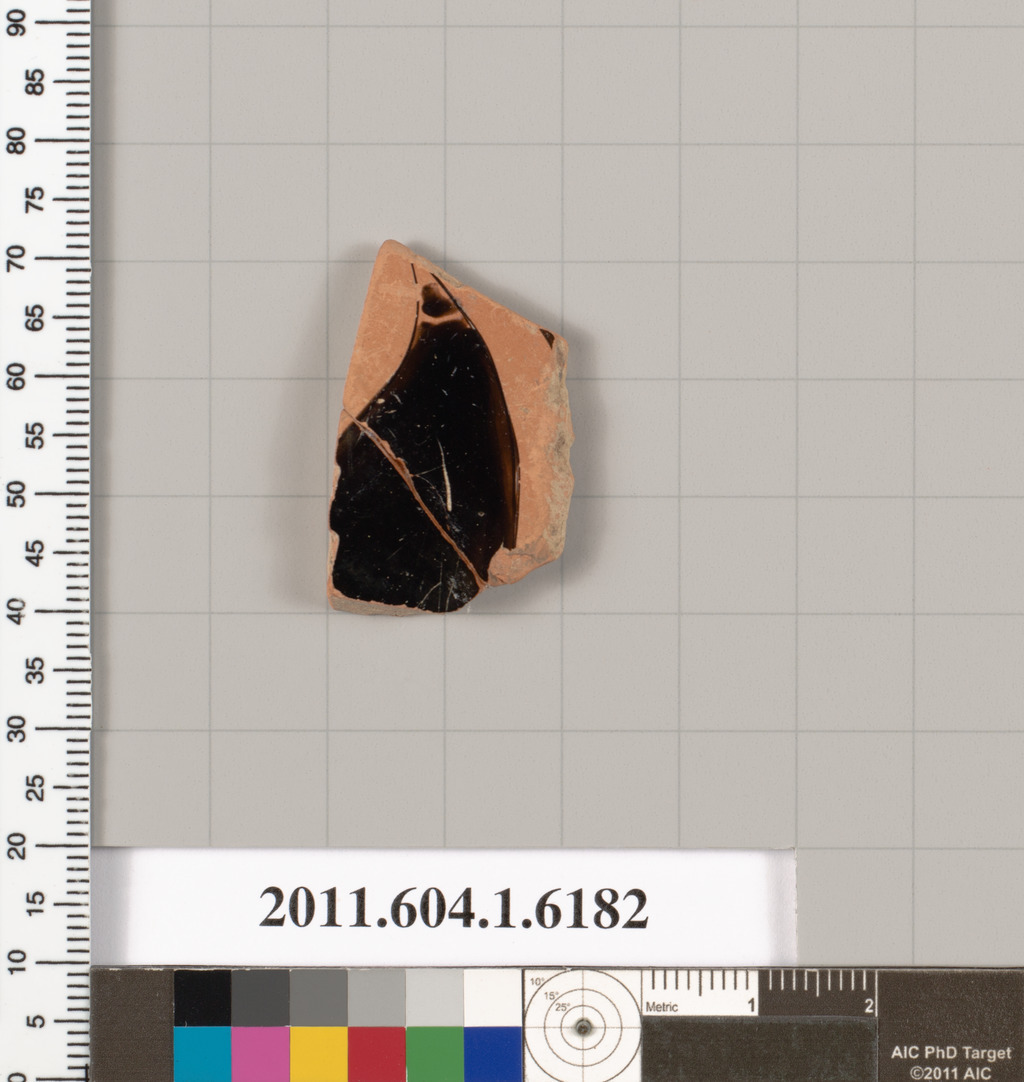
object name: kylix fragment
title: Terracotta fragment of a kylix (drinking cup)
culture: greek, attic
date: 520-500 BCE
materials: terracotta